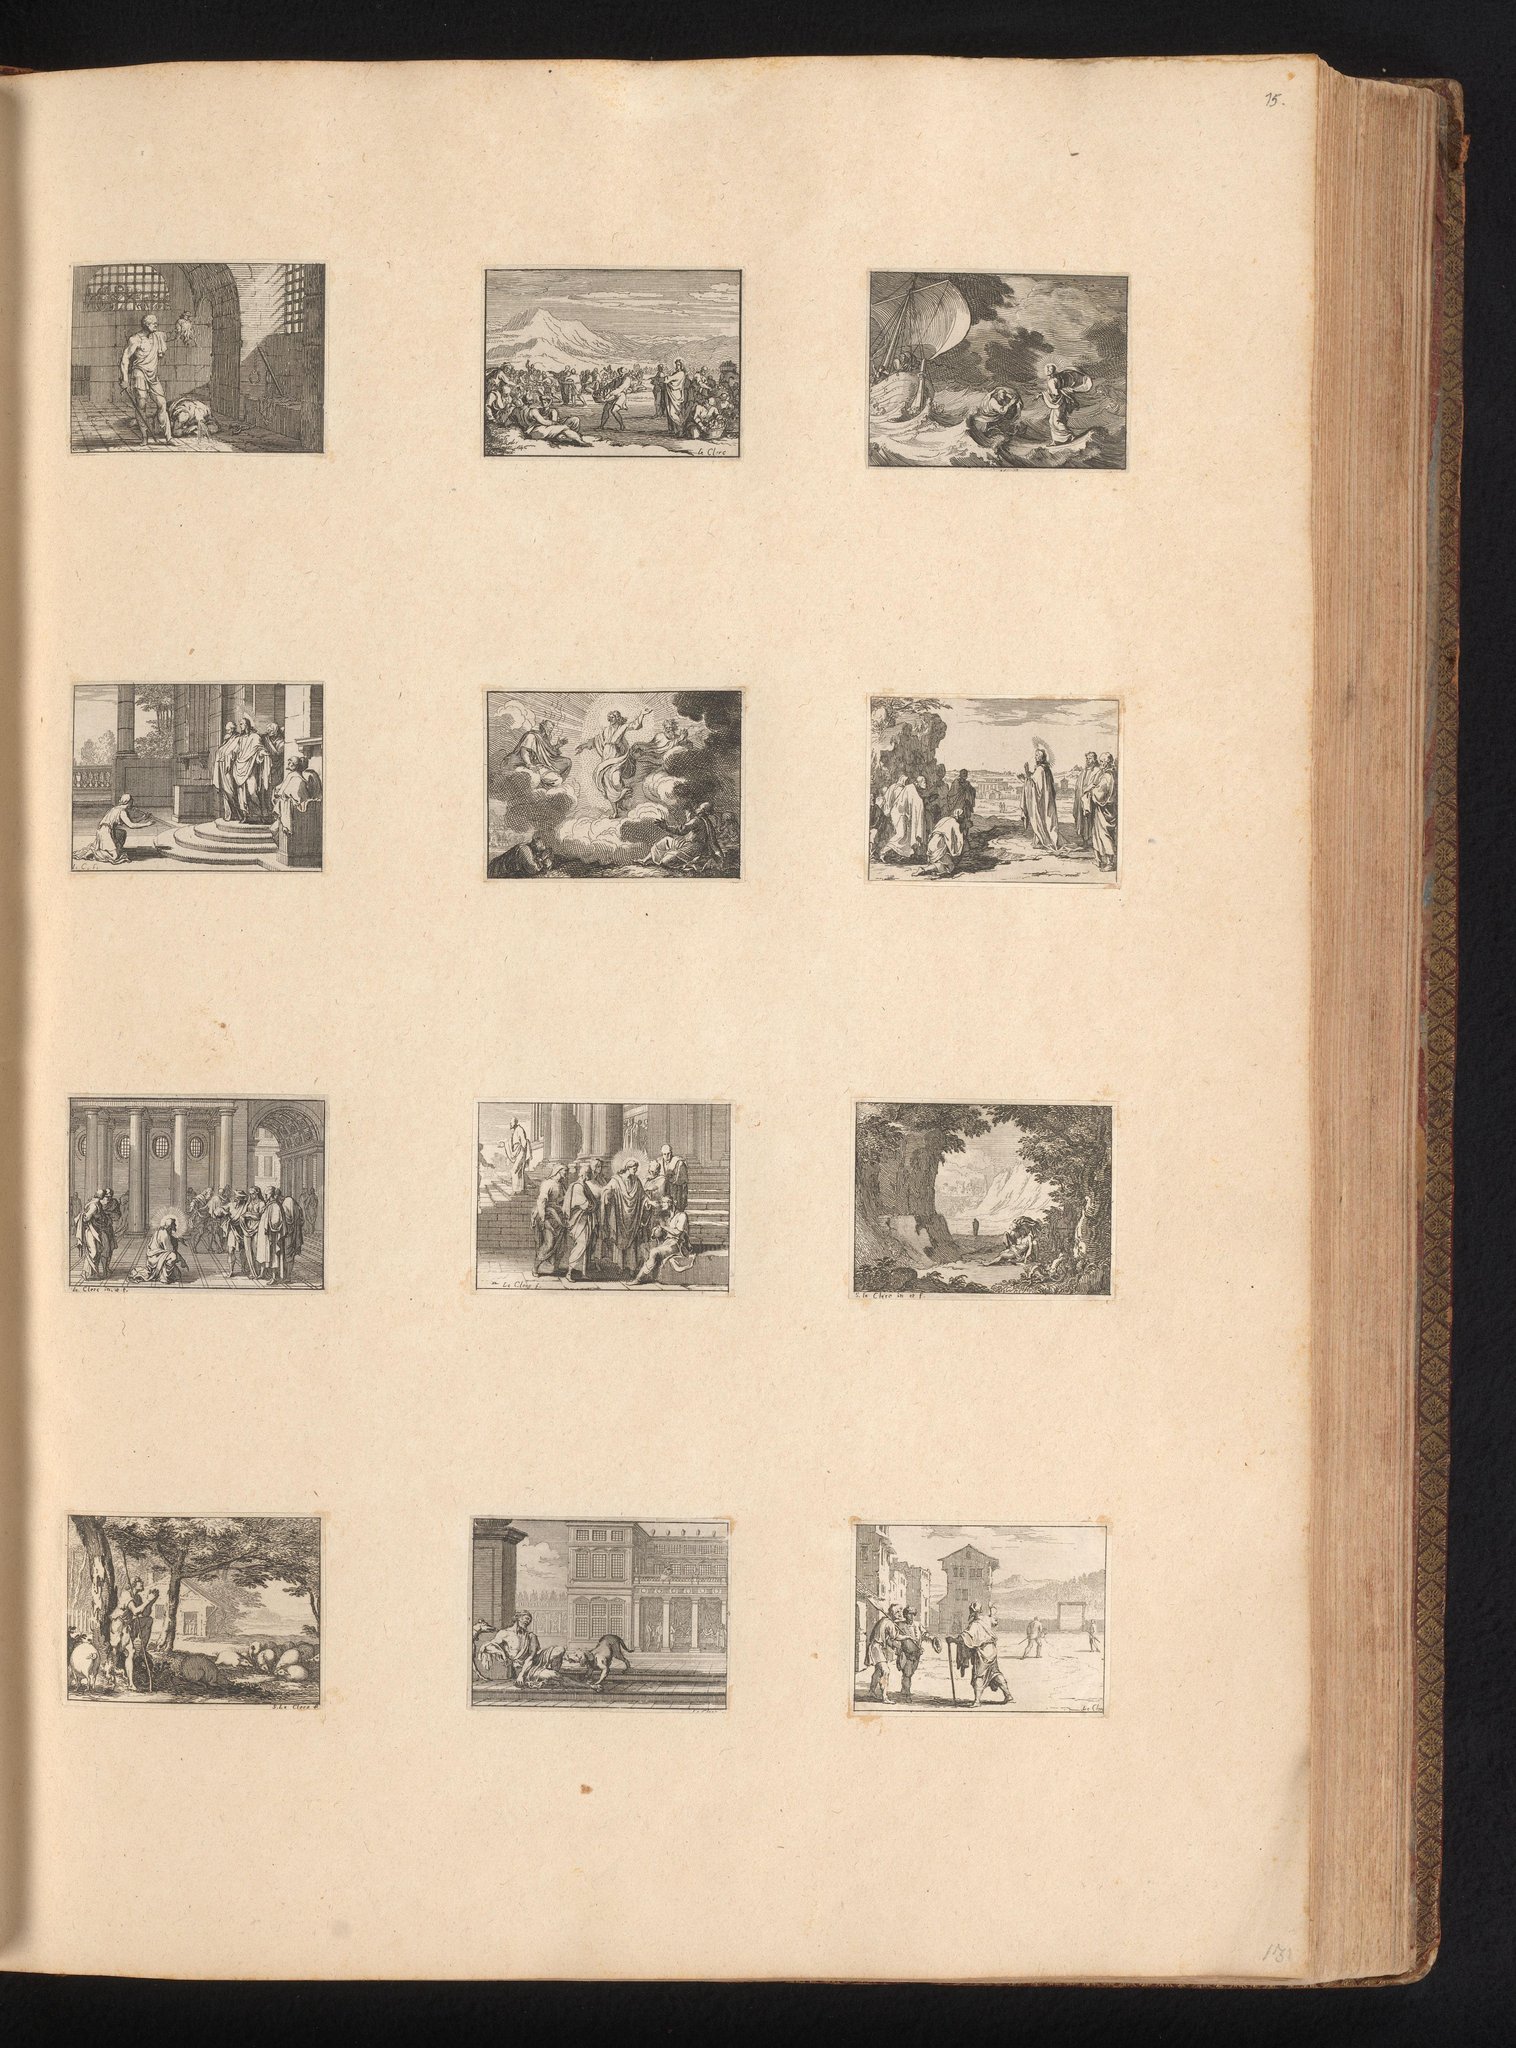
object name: album leaf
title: Twaalf prenten uit: Finé de Brianville, Histoire sacrée en tableaux (...), 1675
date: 1675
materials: paper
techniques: etching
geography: paris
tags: new testament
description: Prenten gebruikt voor het derde deel van: Brianville, Finé de. Histoire sacrée en tableaux (...). Parijs: Charles de Sercy, 1675. In dit boek staan verschillende voorstellingen uit het Nieuwe Testament.